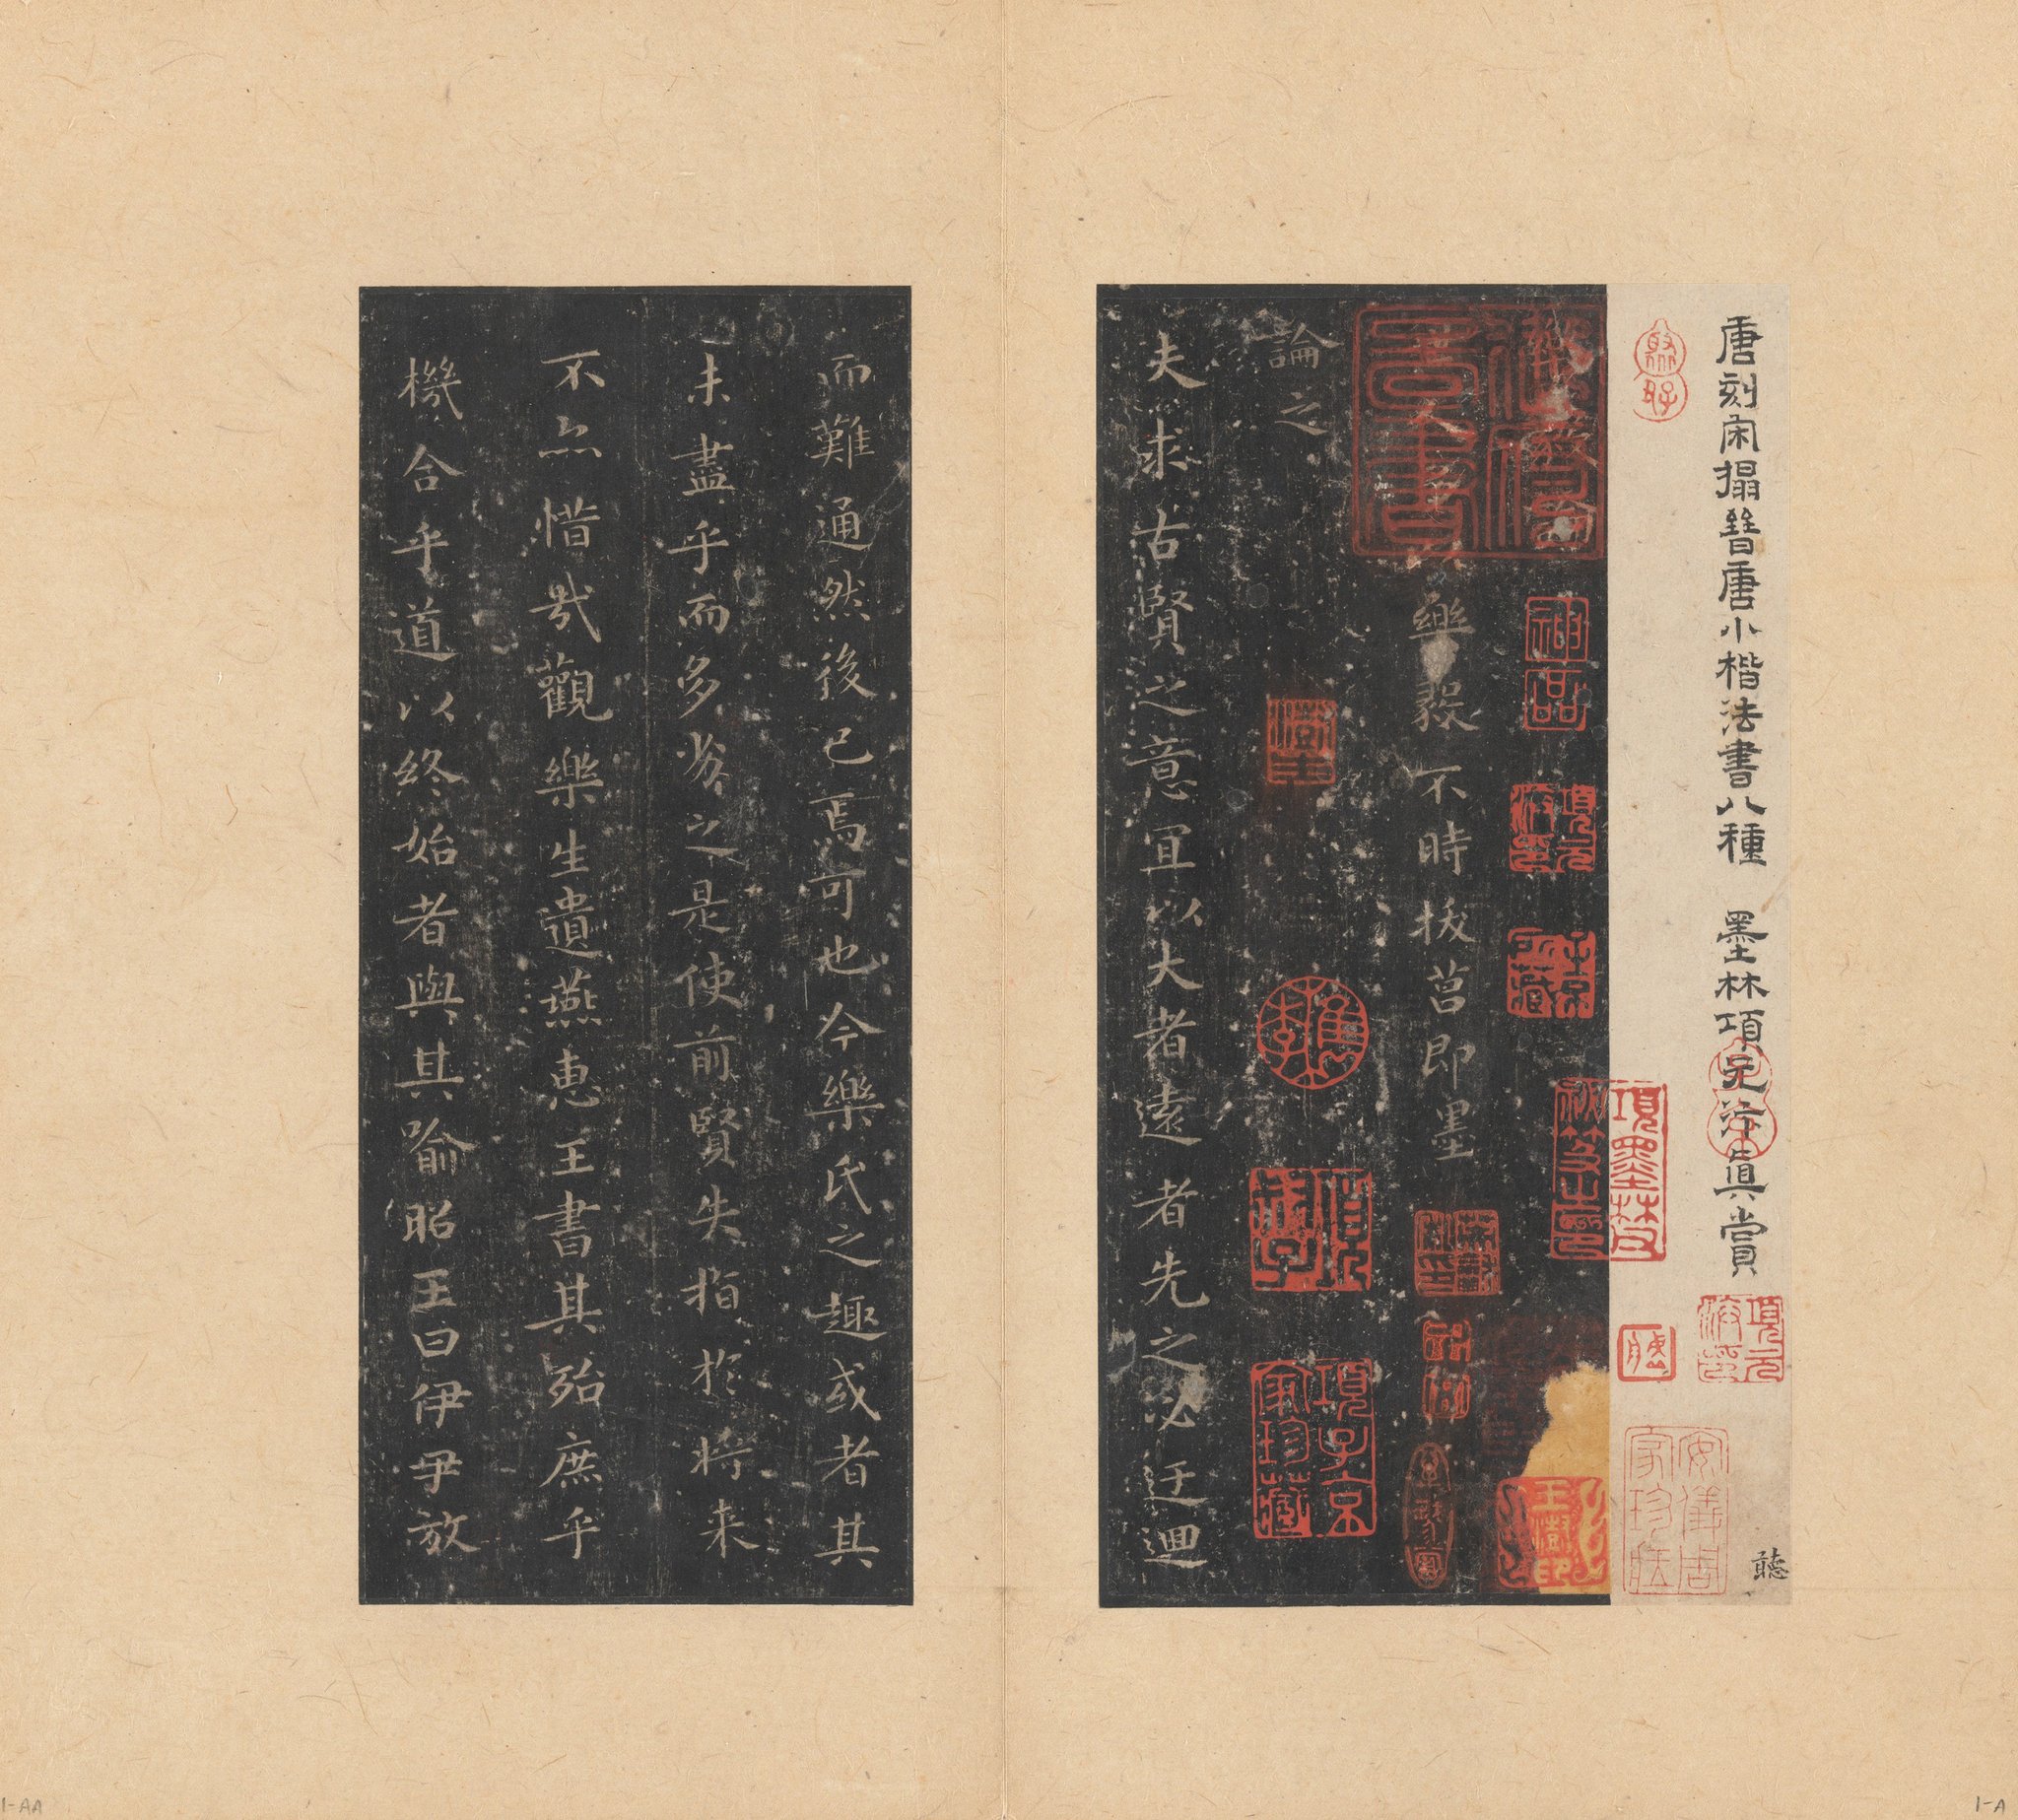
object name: rubbing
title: Eight Kinds of Jin and Tang Writings in Small Standard Script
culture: chinese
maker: various artists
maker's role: artist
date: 1601-1700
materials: ink, paper